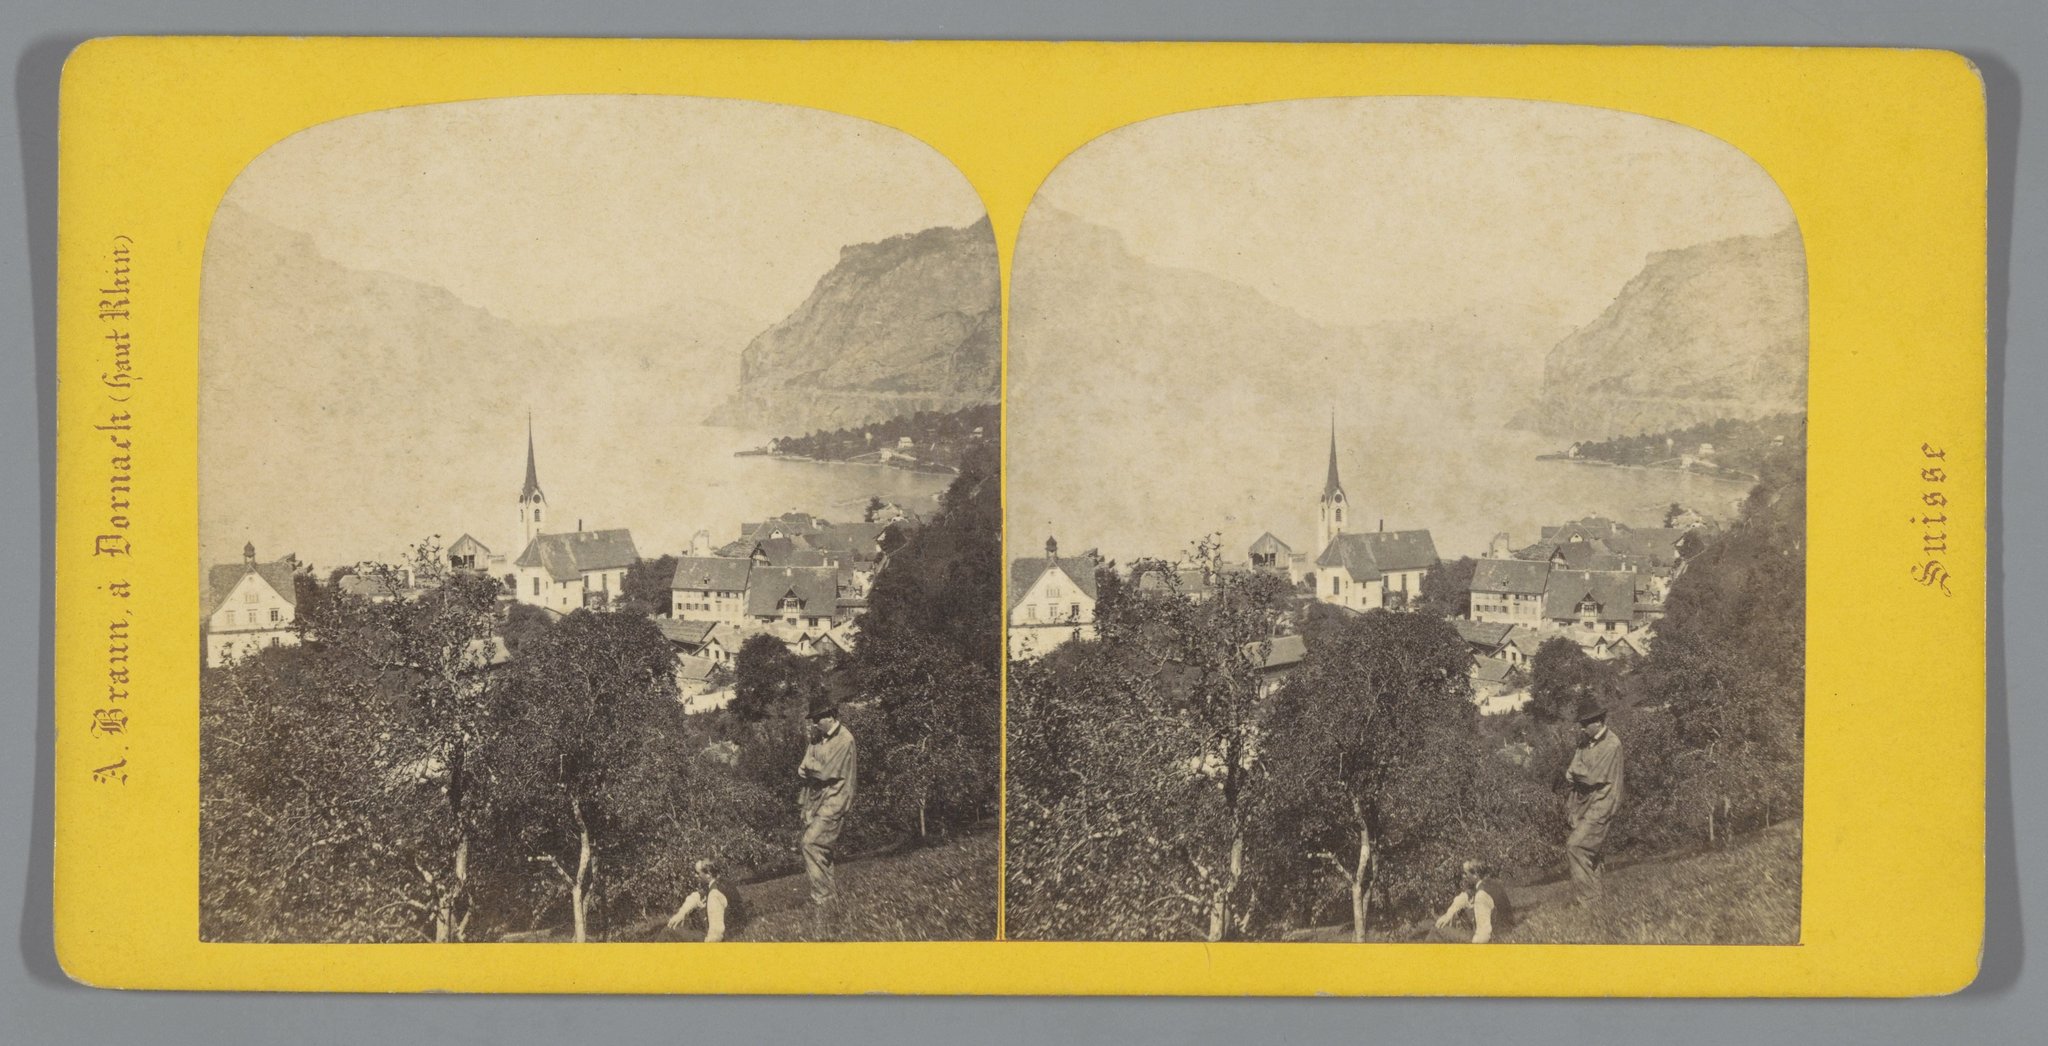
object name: stereograph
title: Lac des IV cantons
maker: Anonymous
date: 1879-1889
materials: cardboard, paper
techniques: albumen print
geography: dornach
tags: city-view in general; 'veduta', lake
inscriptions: number: ‘No 5801.’